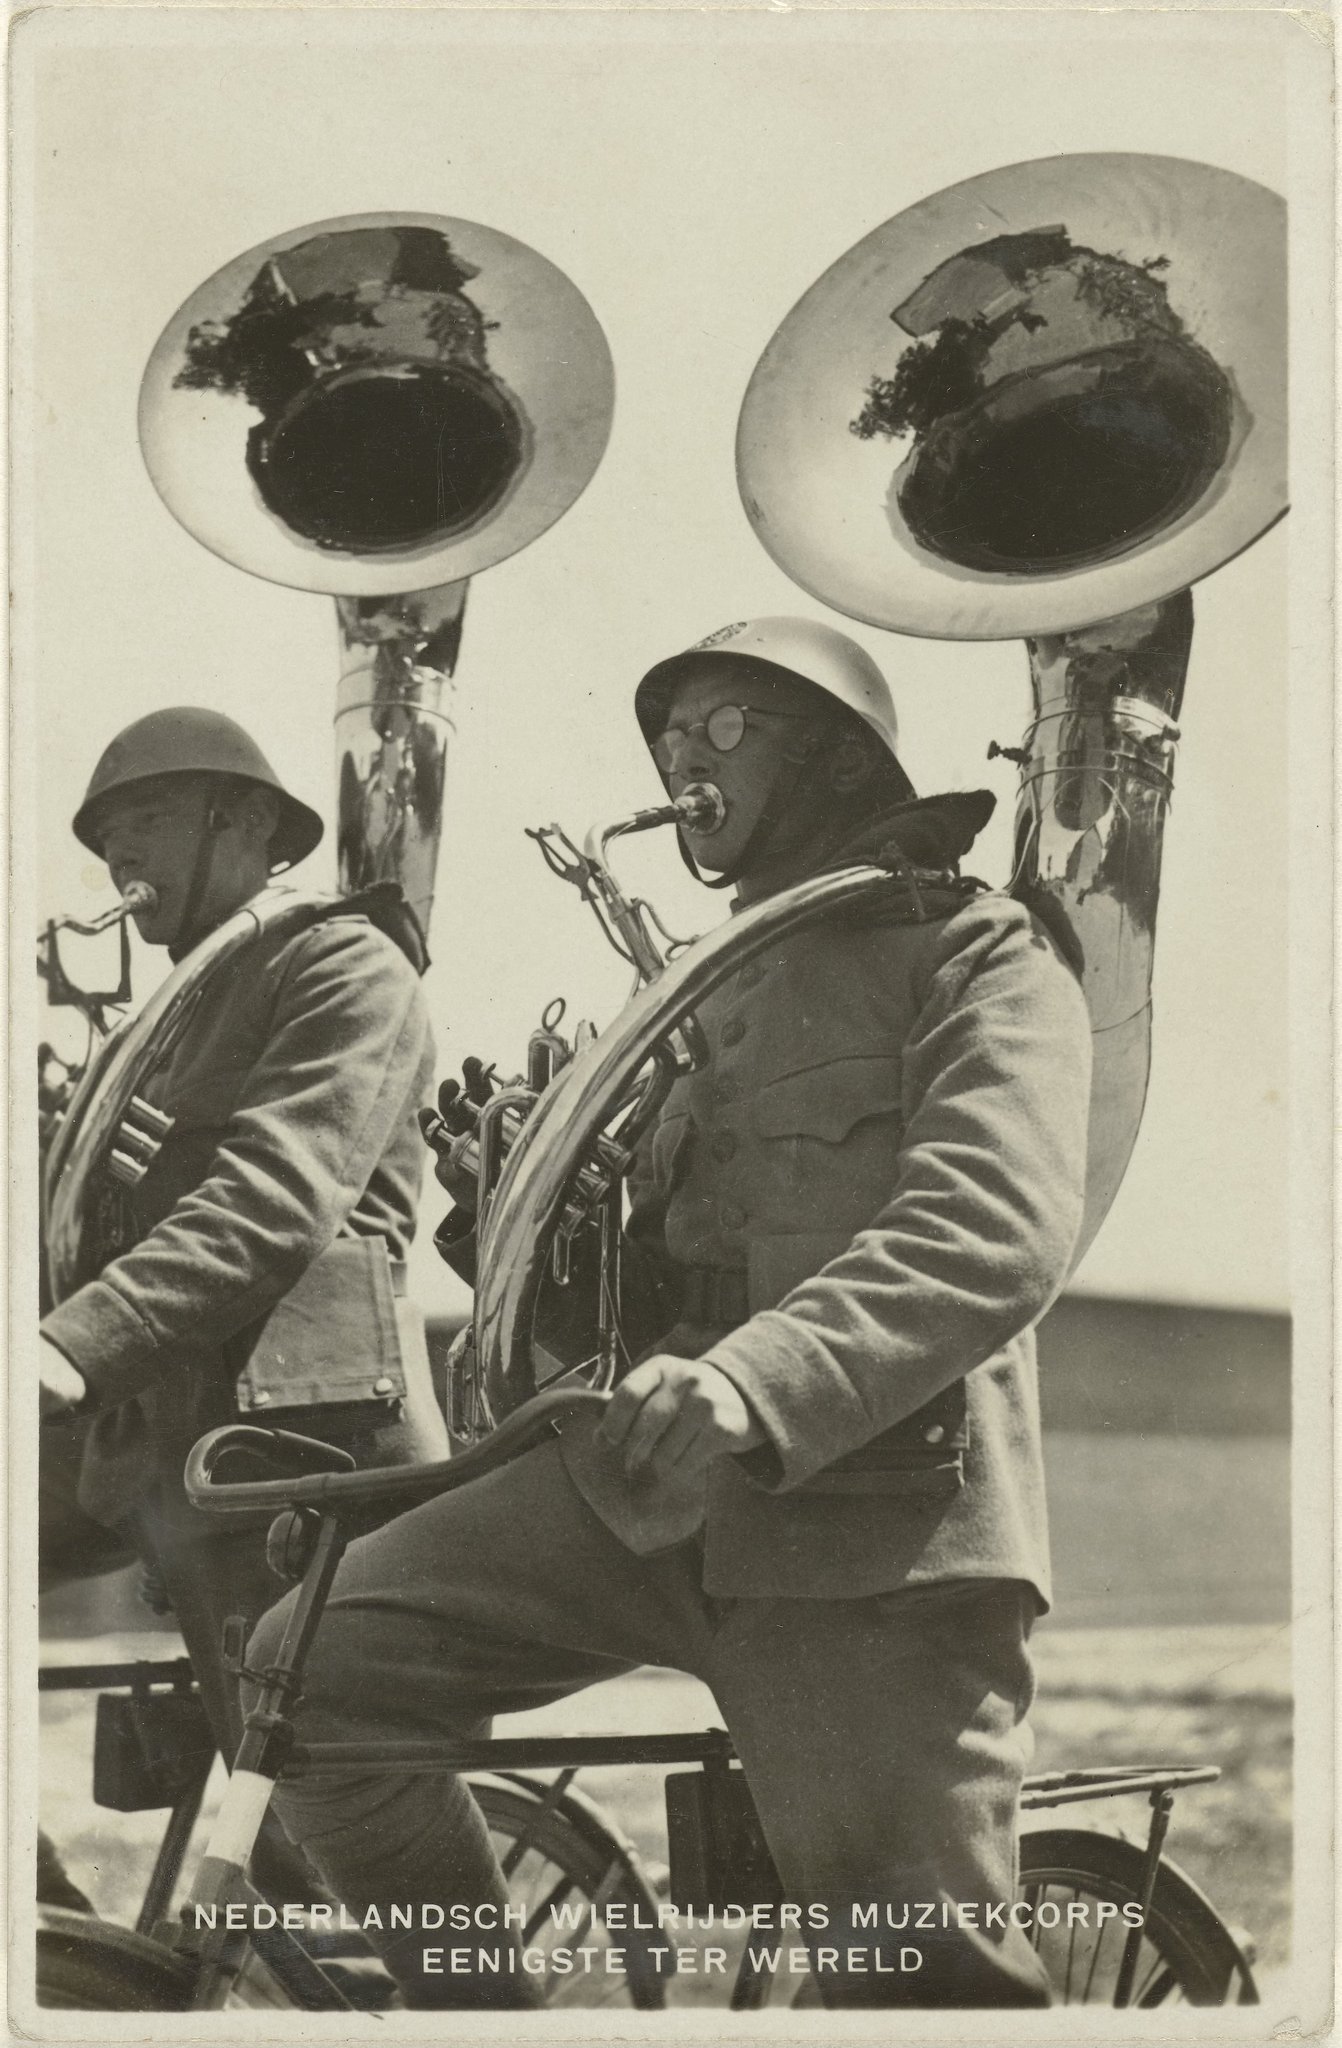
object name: photograph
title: Militair muziekcorps op de fiets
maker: Anonymous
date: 1925-1935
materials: photographic support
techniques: gelatin silver print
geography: netherlands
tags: musical instruments; group of musical instruments, making music; musician with instrument, bicycle, netherlands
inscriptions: annotation: ‘uitg. Ch Kellerman, Rotterdam’